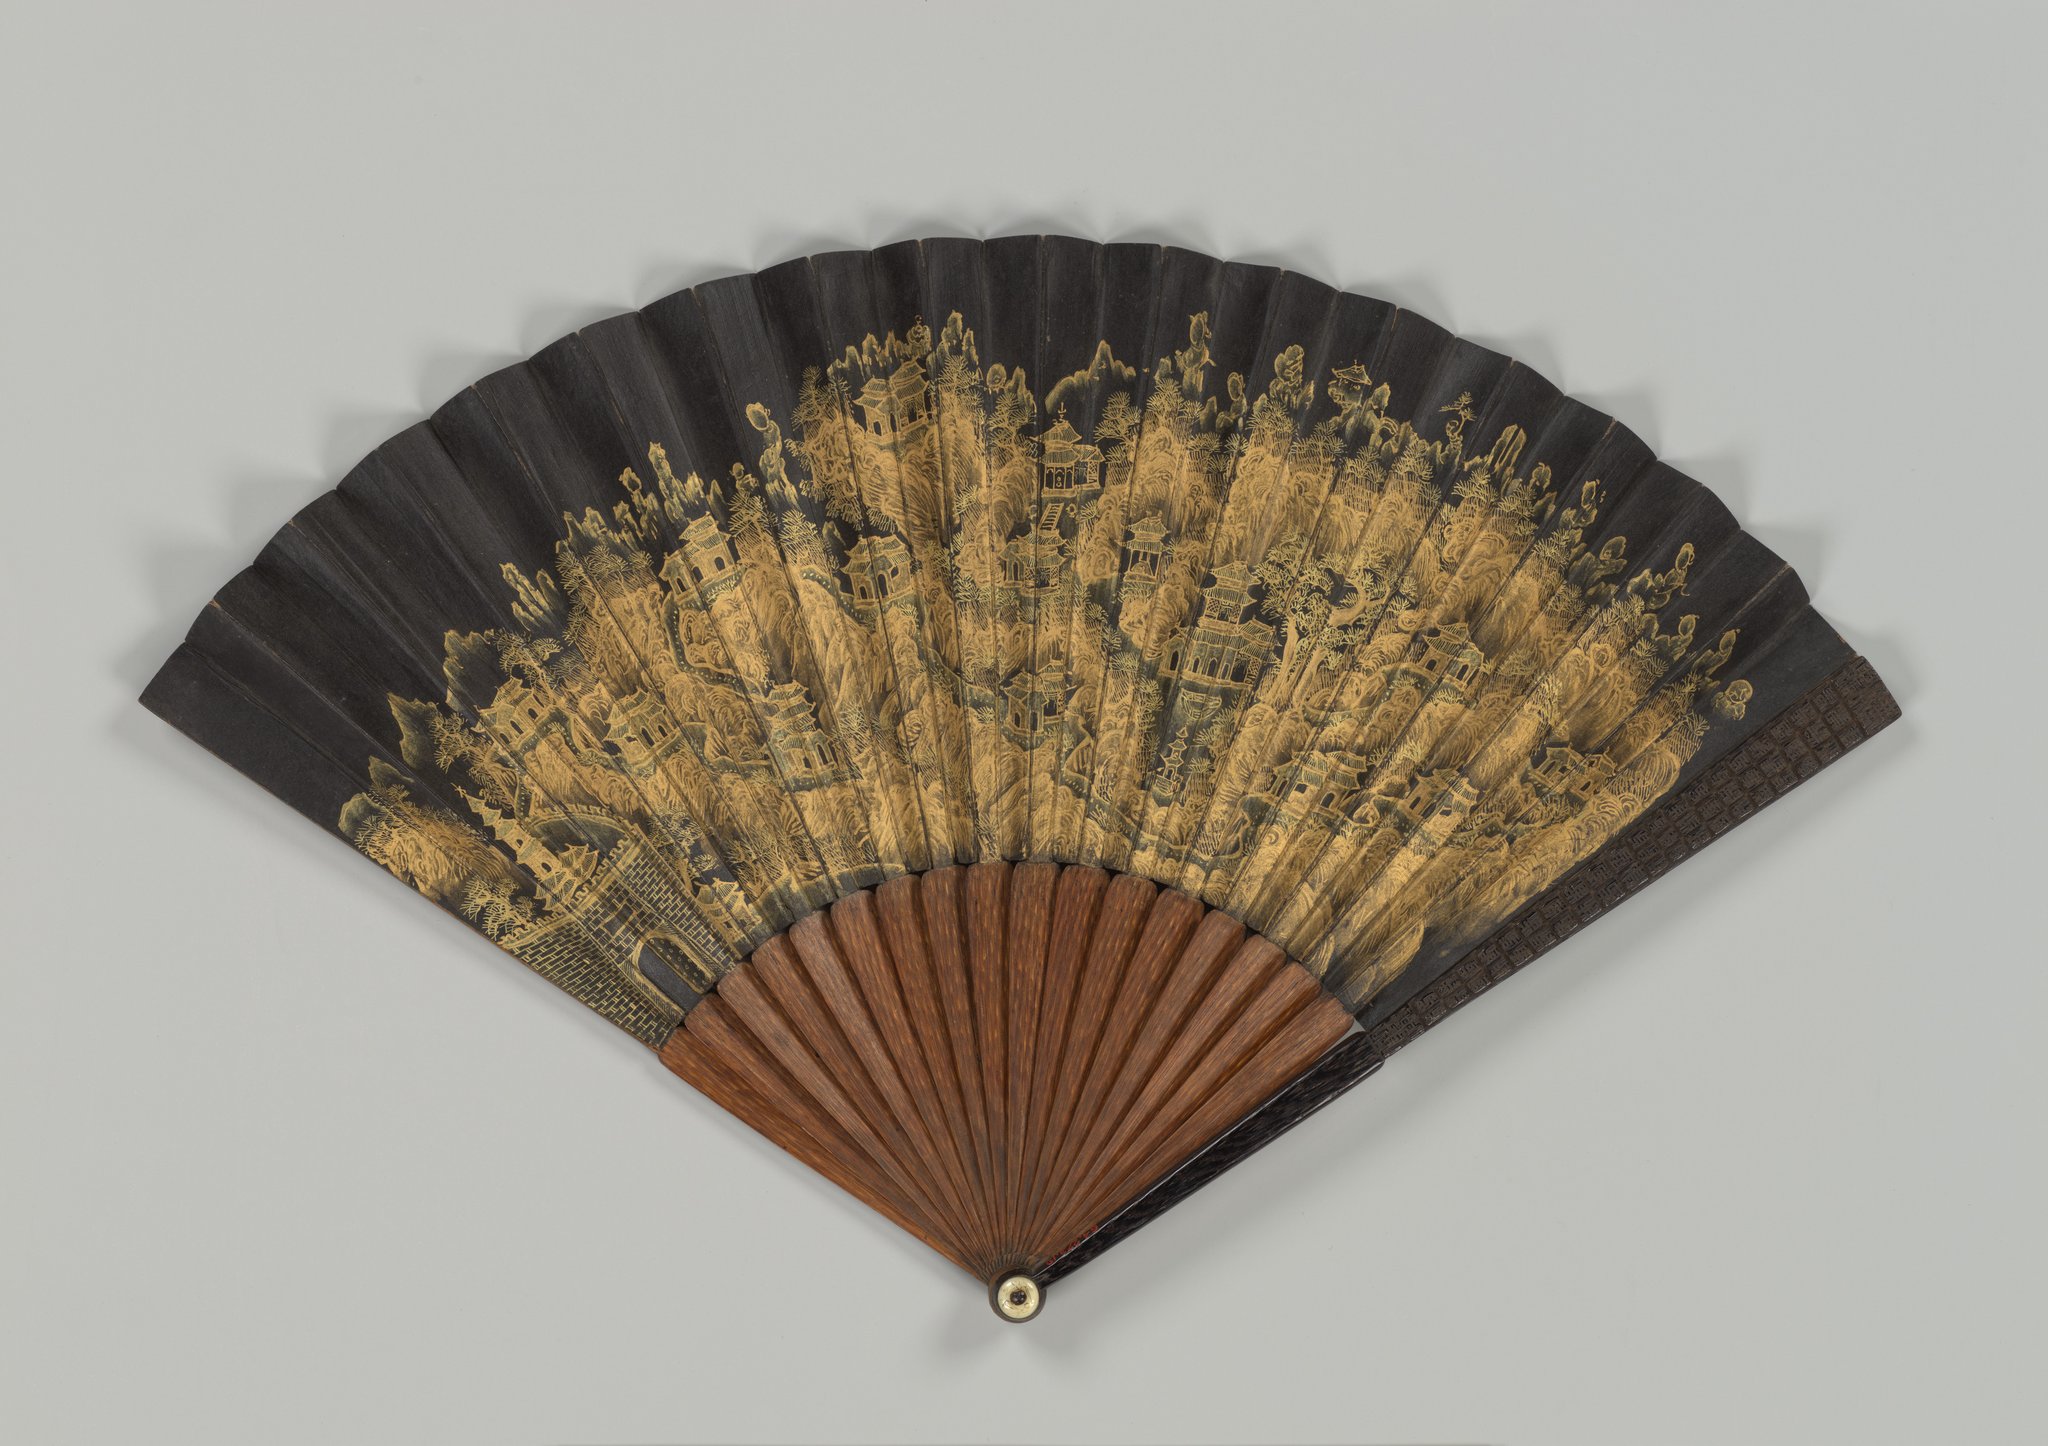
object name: folding fan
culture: chinese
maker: unidentified artist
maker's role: artist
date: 1801-1900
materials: paper, wood